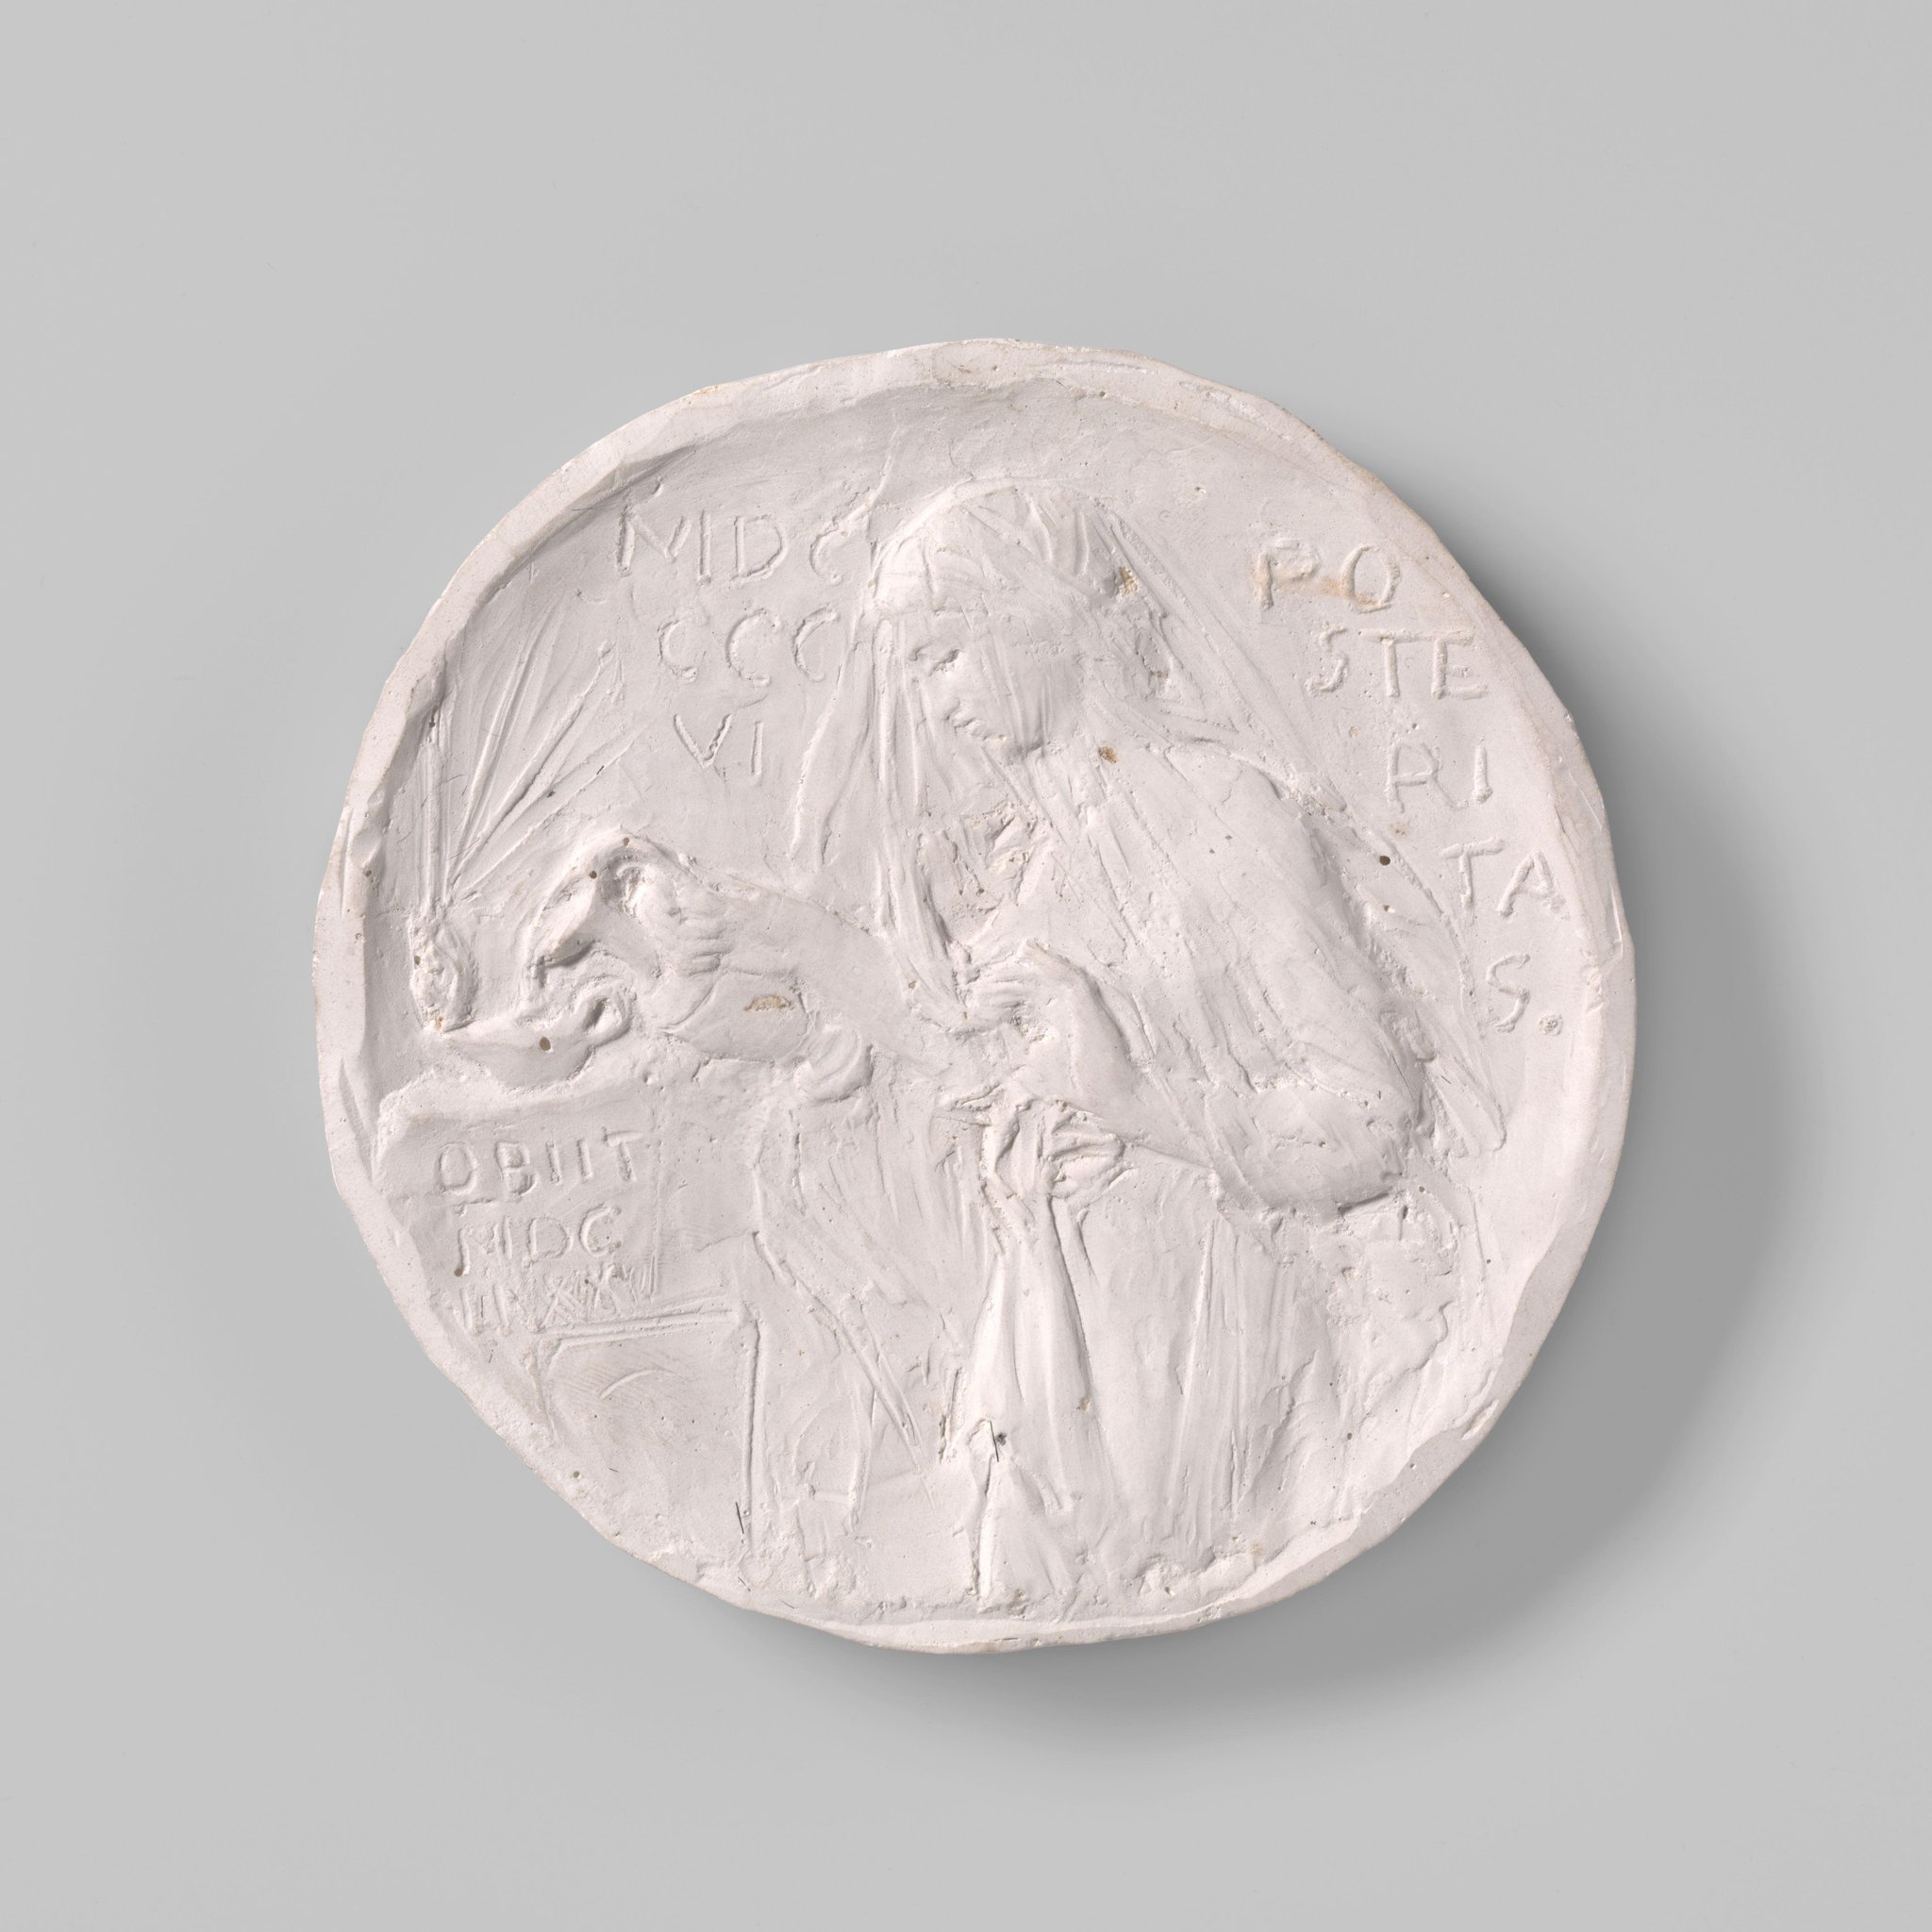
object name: medal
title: Voorstudie in gips voor Rembrandt-penning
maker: johan melchior faddegon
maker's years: 1871-1941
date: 1906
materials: gypsum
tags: leiden, amsterdam, print maker, draughtsman, rembrandt van rijn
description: Voorstudie in gips voor Rembrandt-penning.